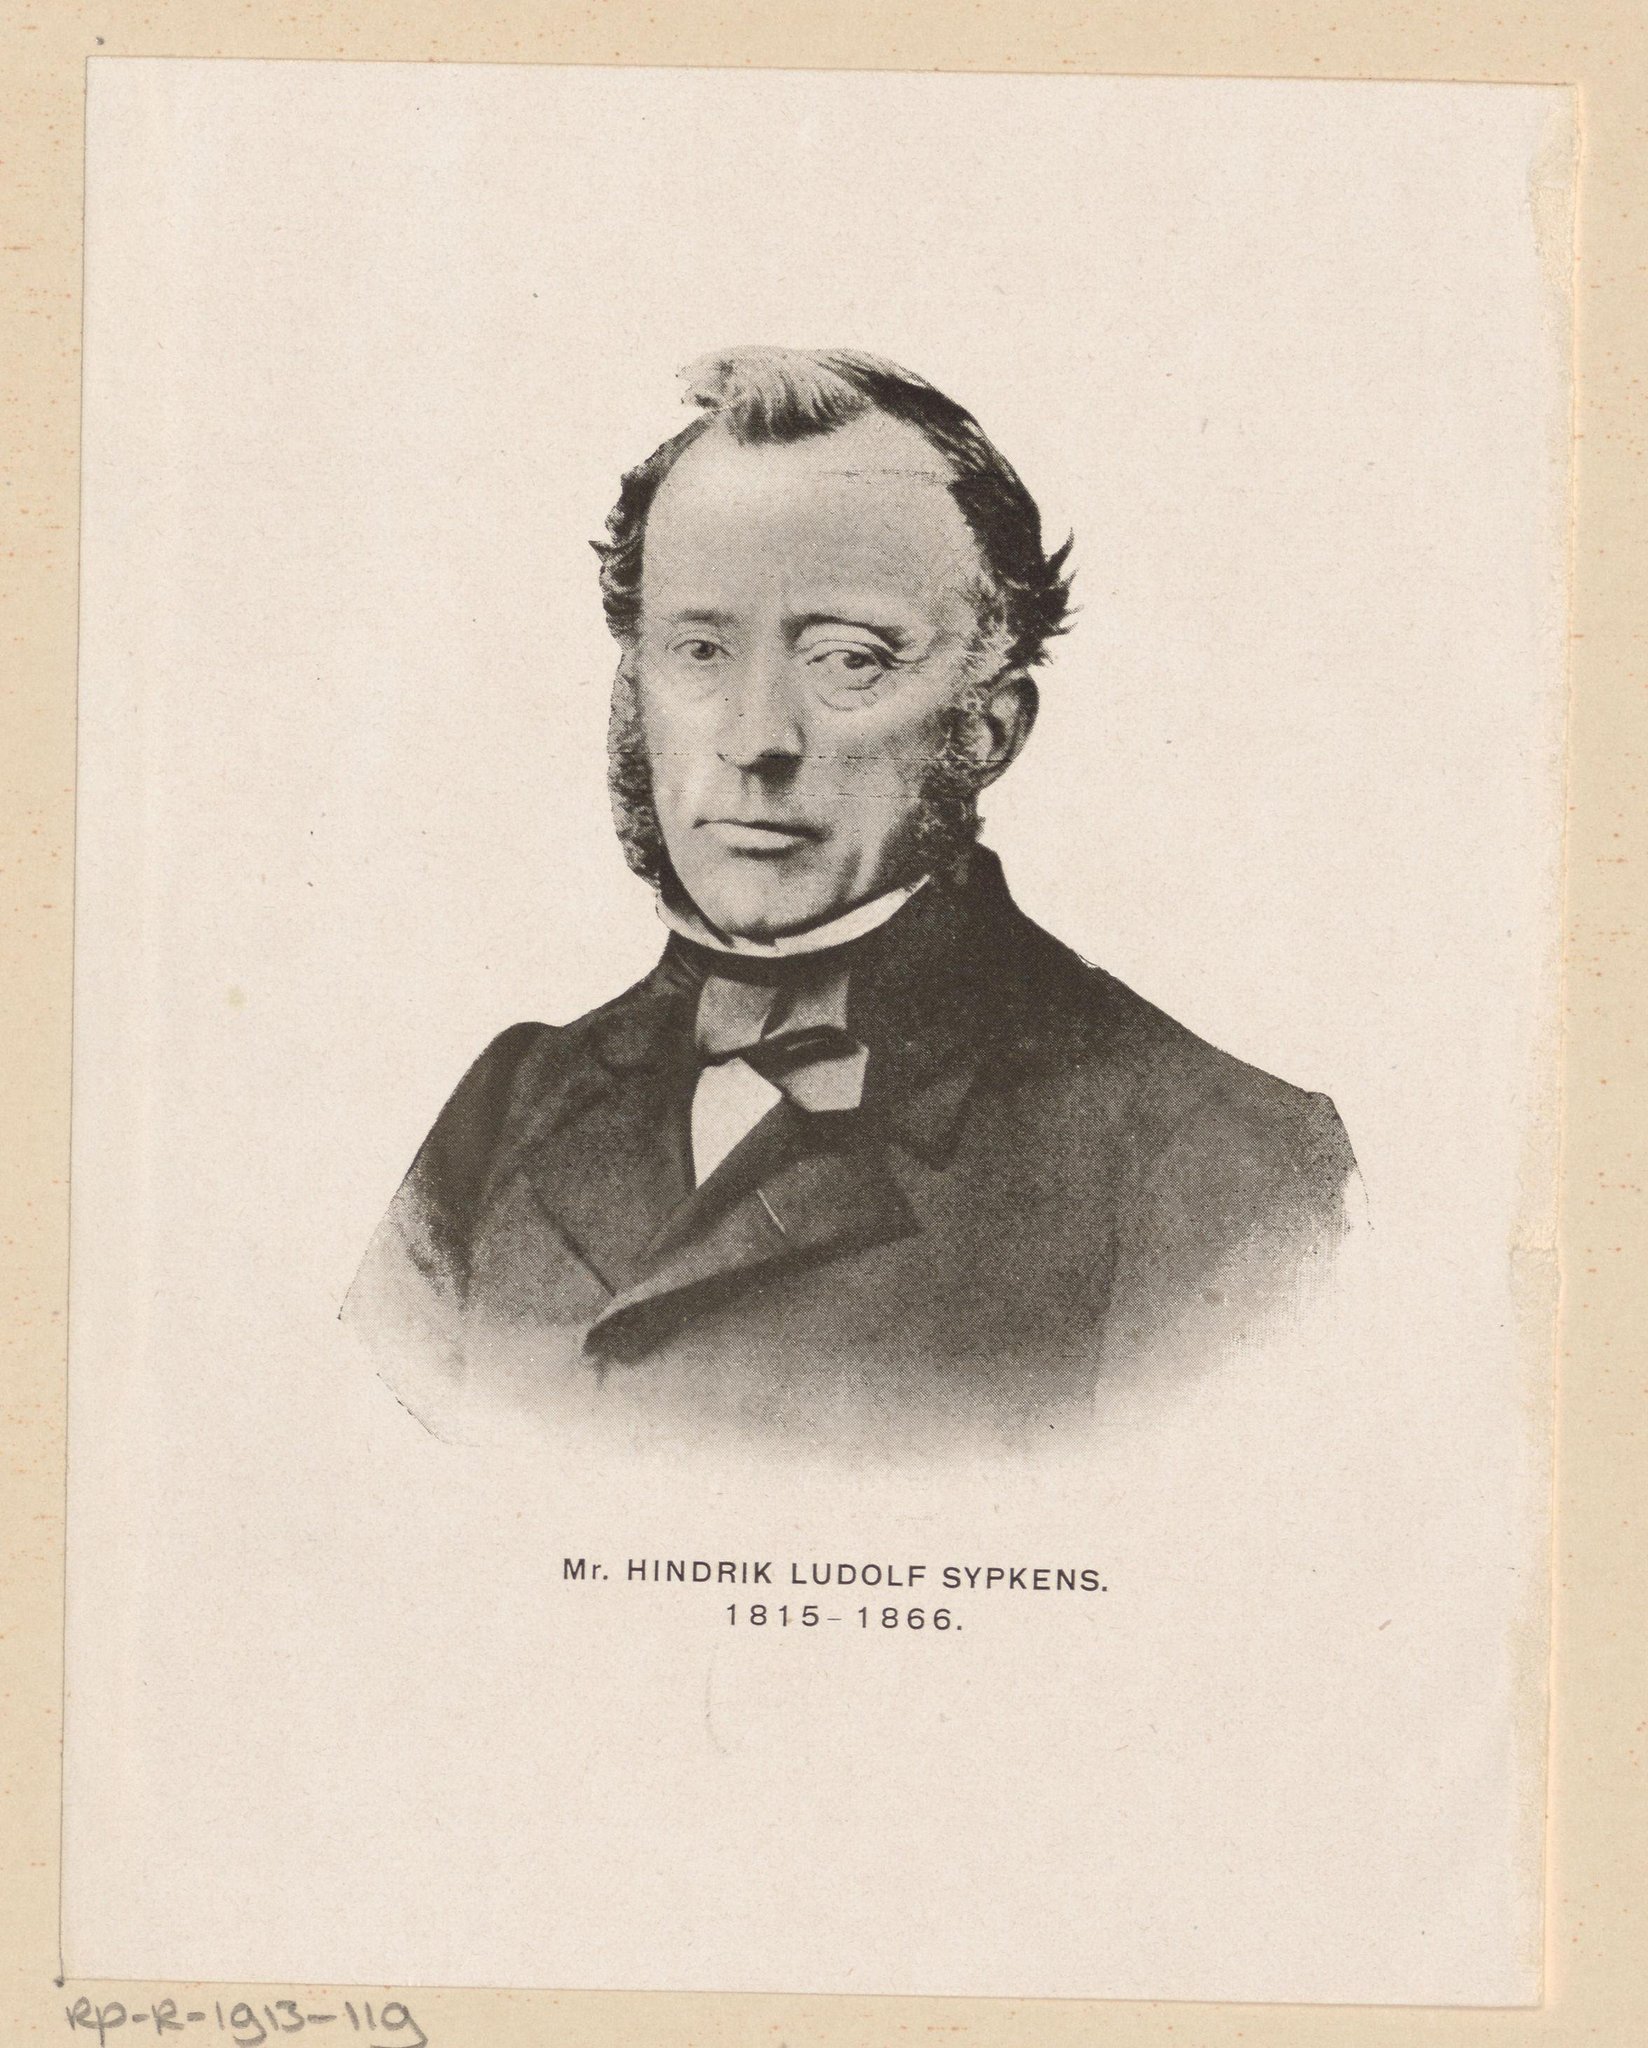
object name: reproduction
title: Portret van Hindrik Ludolf Sypkens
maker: Anonymous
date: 1913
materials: paper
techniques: autotype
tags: historical persons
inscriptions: collector's mark: Lugt 2228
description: Prent mogelijk uit: Nederland's Patriciaat, 1913.